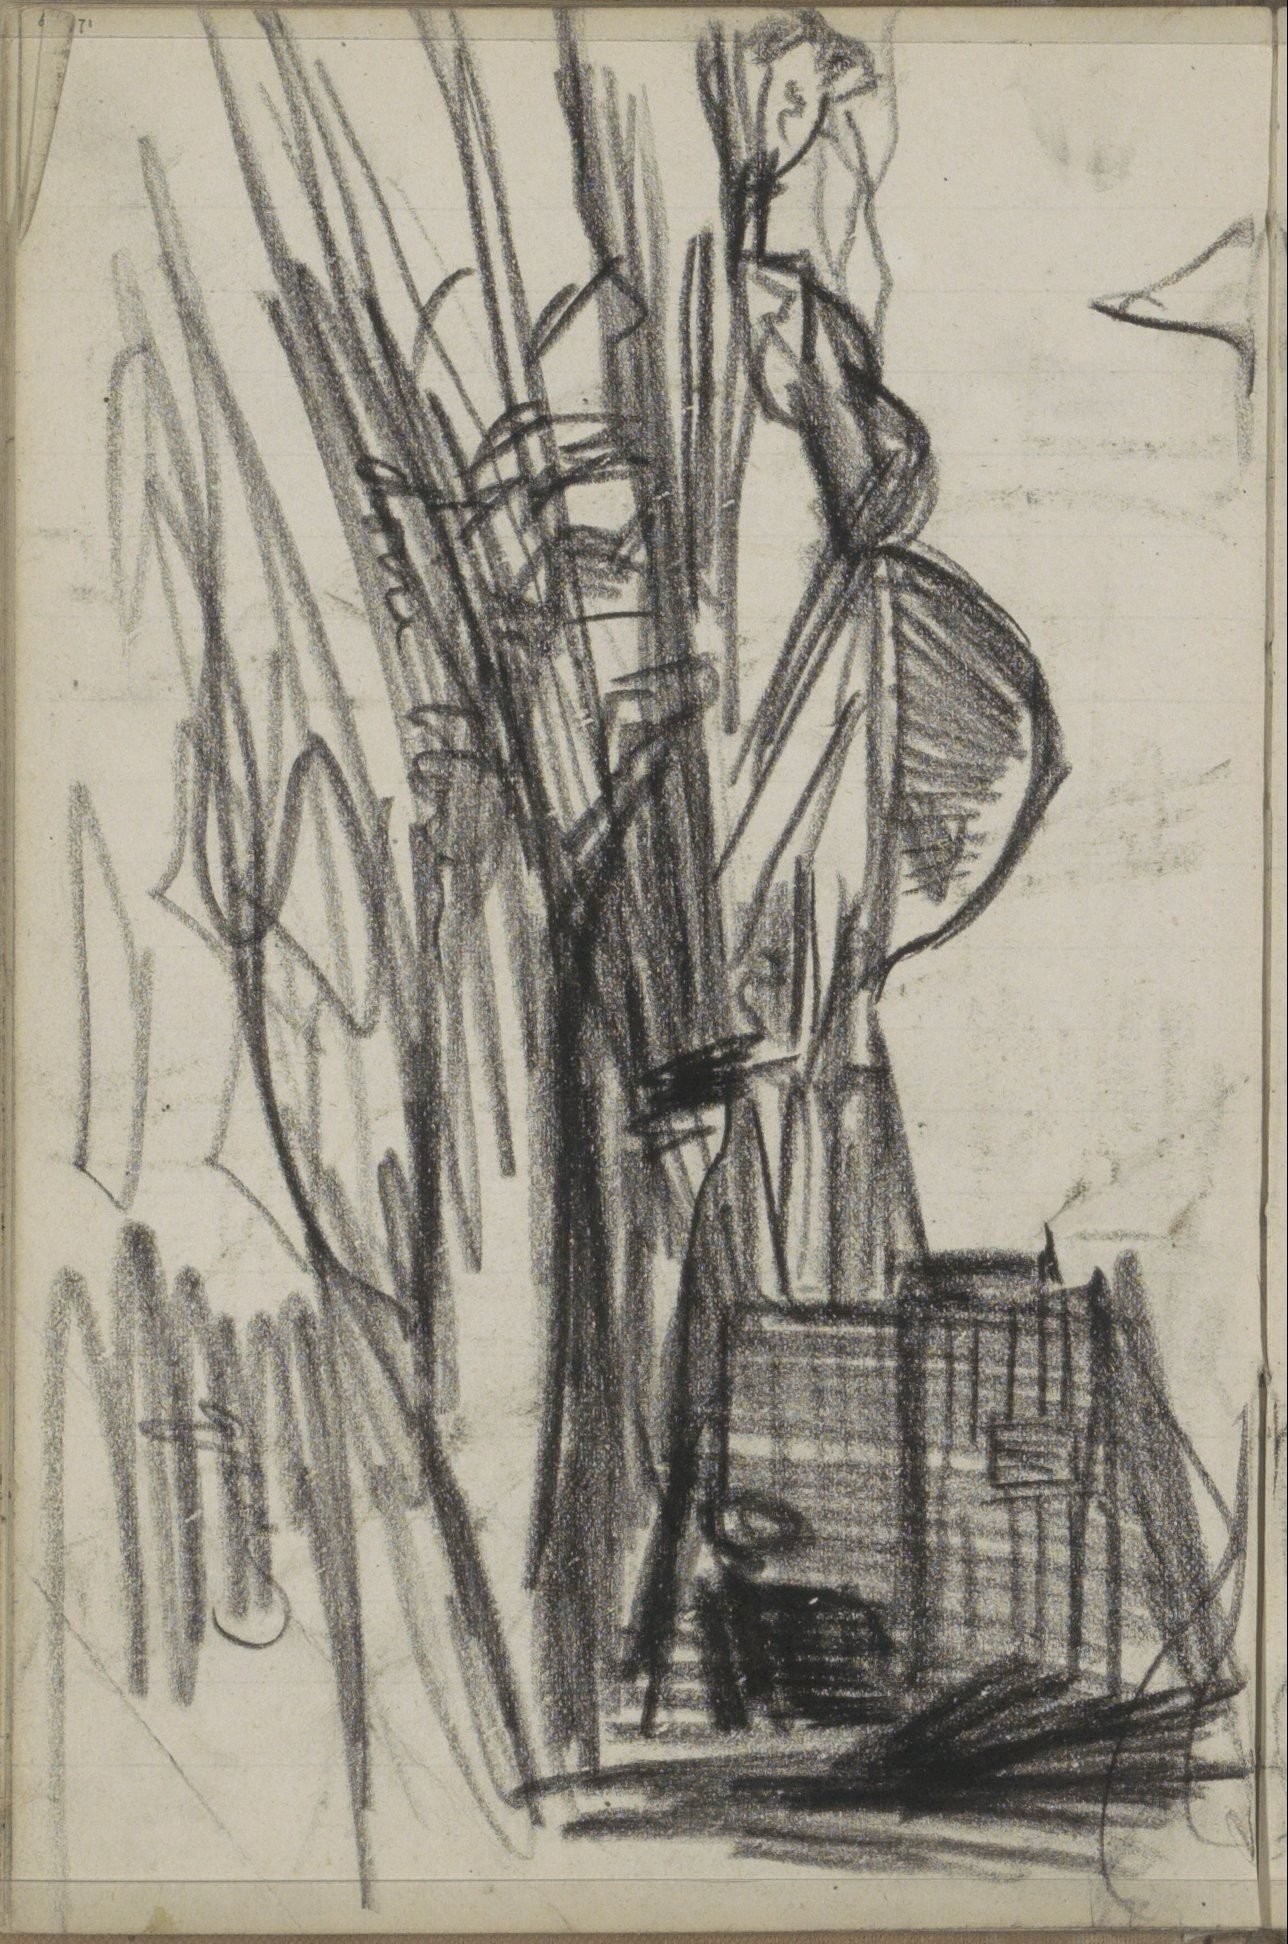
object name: sketchbook leaf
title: Heuvelachtig landschap met een huis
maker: marius bauer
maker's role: draughtsman, print maker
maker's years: 1867-1932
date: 1888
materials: chalk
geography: istanbul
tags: low hill country, housing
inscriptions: kleurnotitie, handgeschreven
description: Pagina 71 uit een schetsboek met 56 bladen.